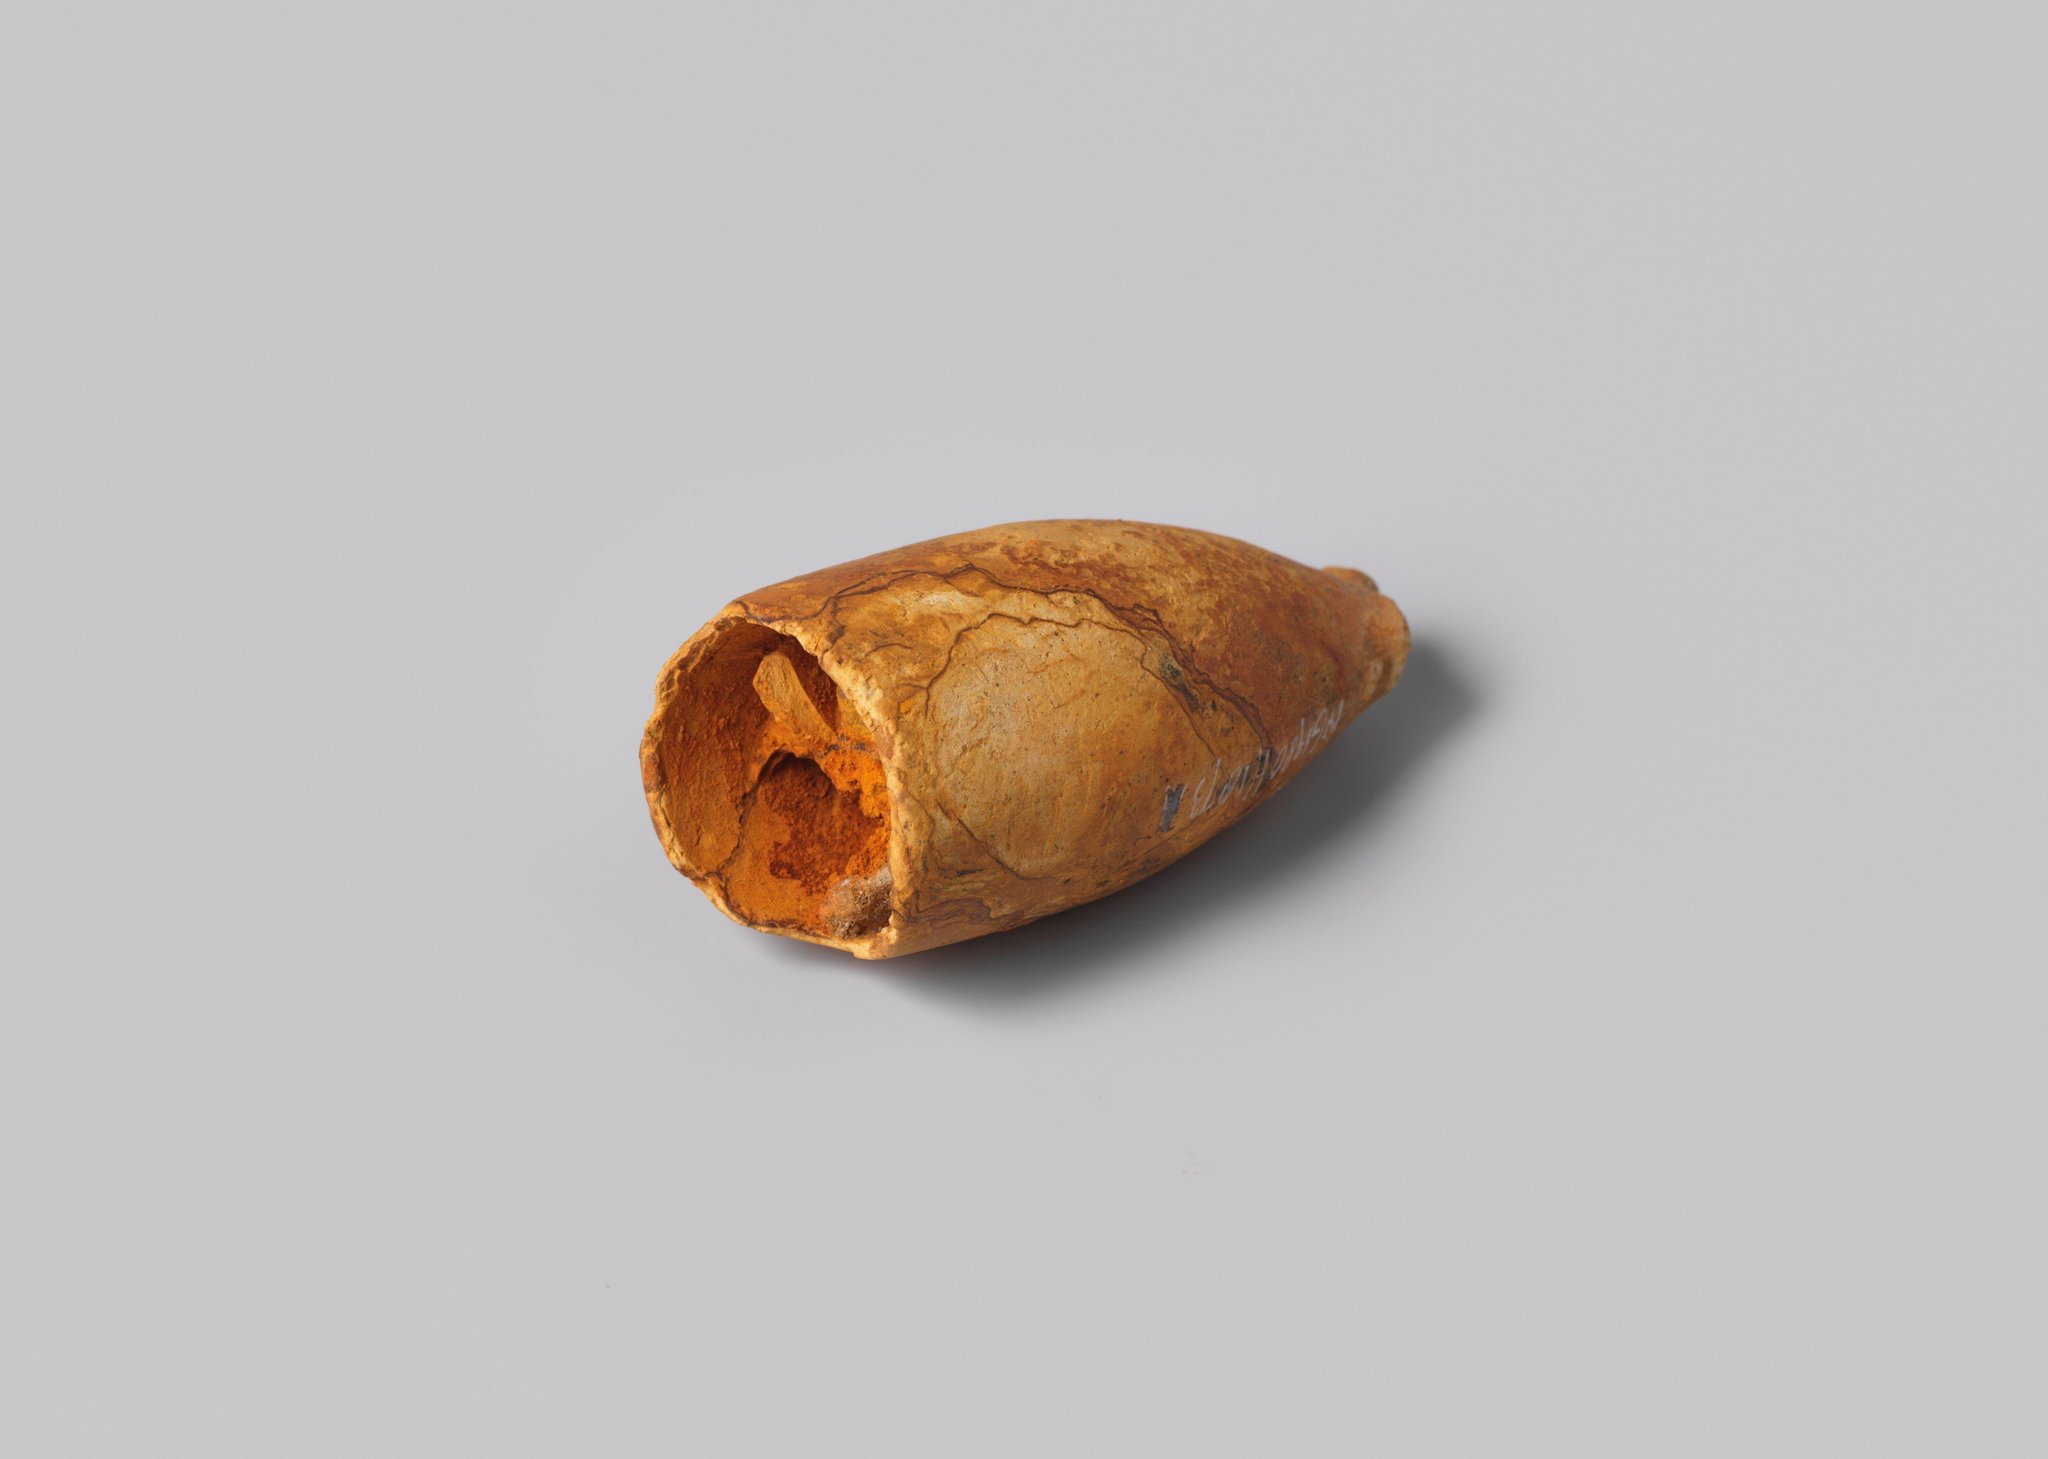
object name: pipe bowl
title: Fragment pijpenkop uit het wrak van de Oost-Indiëvaarder Hollandia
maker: Anonymous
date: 1700-1743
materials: clay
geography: netherlands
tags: verenigde oostindische compagnie, hollandia (schip), annet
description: Pipe, bowl, heelmark illegible; fragment, no hsm.